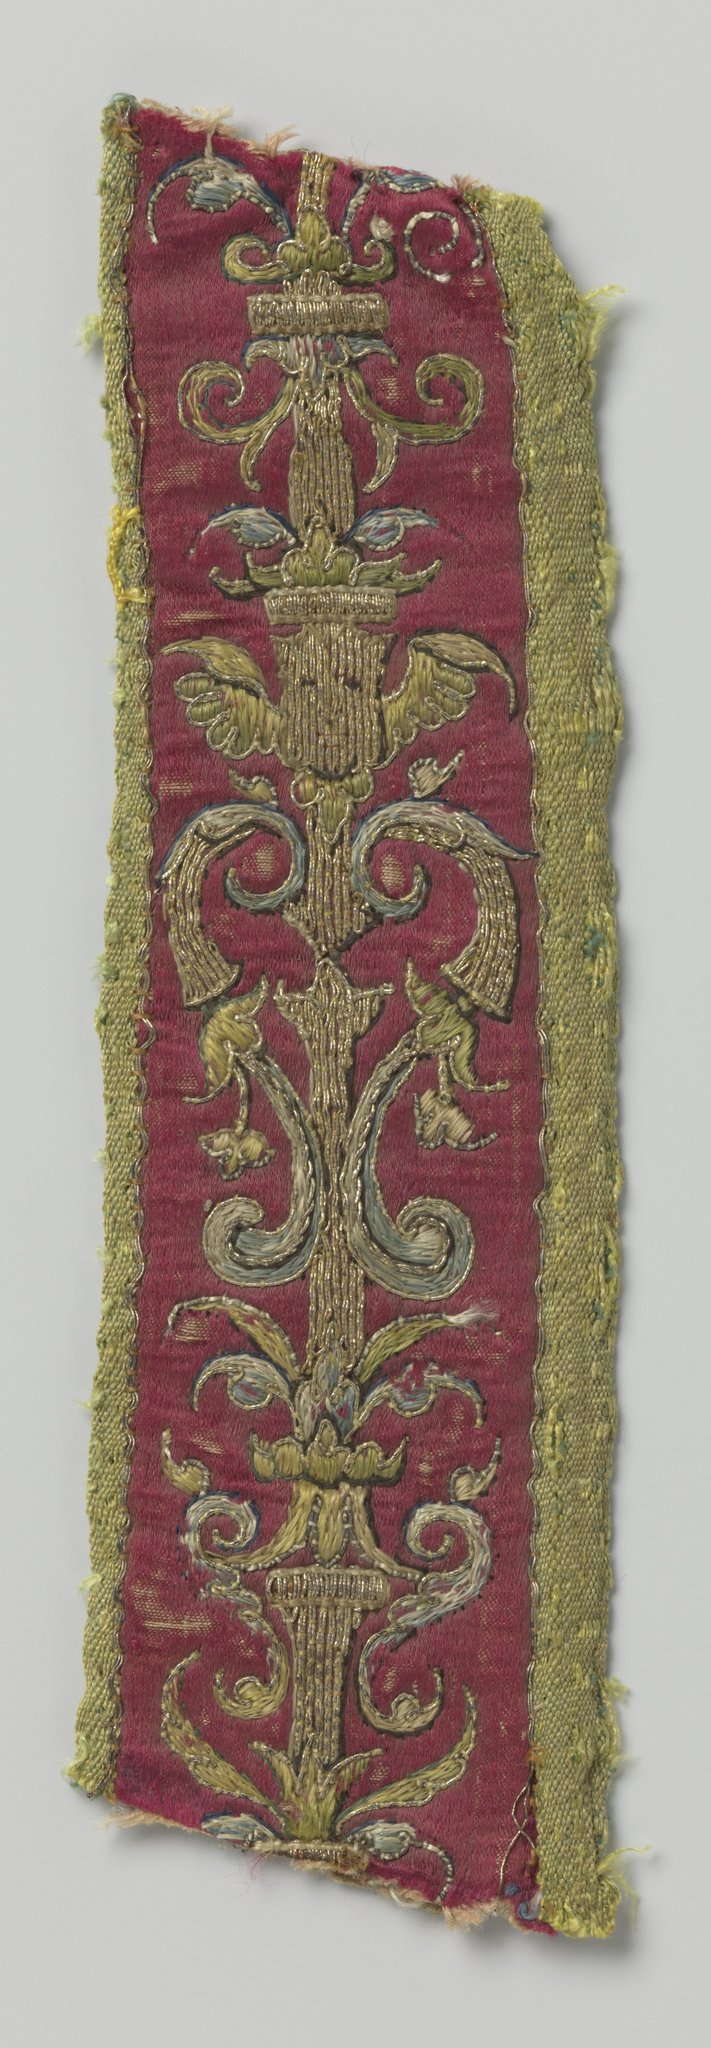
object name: embroidery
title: Fragment van een borduursel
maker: Anonymous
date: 1500-1600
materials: gold thread, linen, textile, silk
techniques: embroidered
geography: netherlands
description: Fragment van een geborduurde praetexta of aurifries van een dalmatiek. Het fragment bestaat uit rood satijn op een linnen voering. Het borduurwerk heeft rinceaux van goud en zijde in de kleuren geel en groen. Het fragment hoort bij twee fragmenten met invnrs. BK-NM-1239-B-1 en BK-NM-1239-B-2.